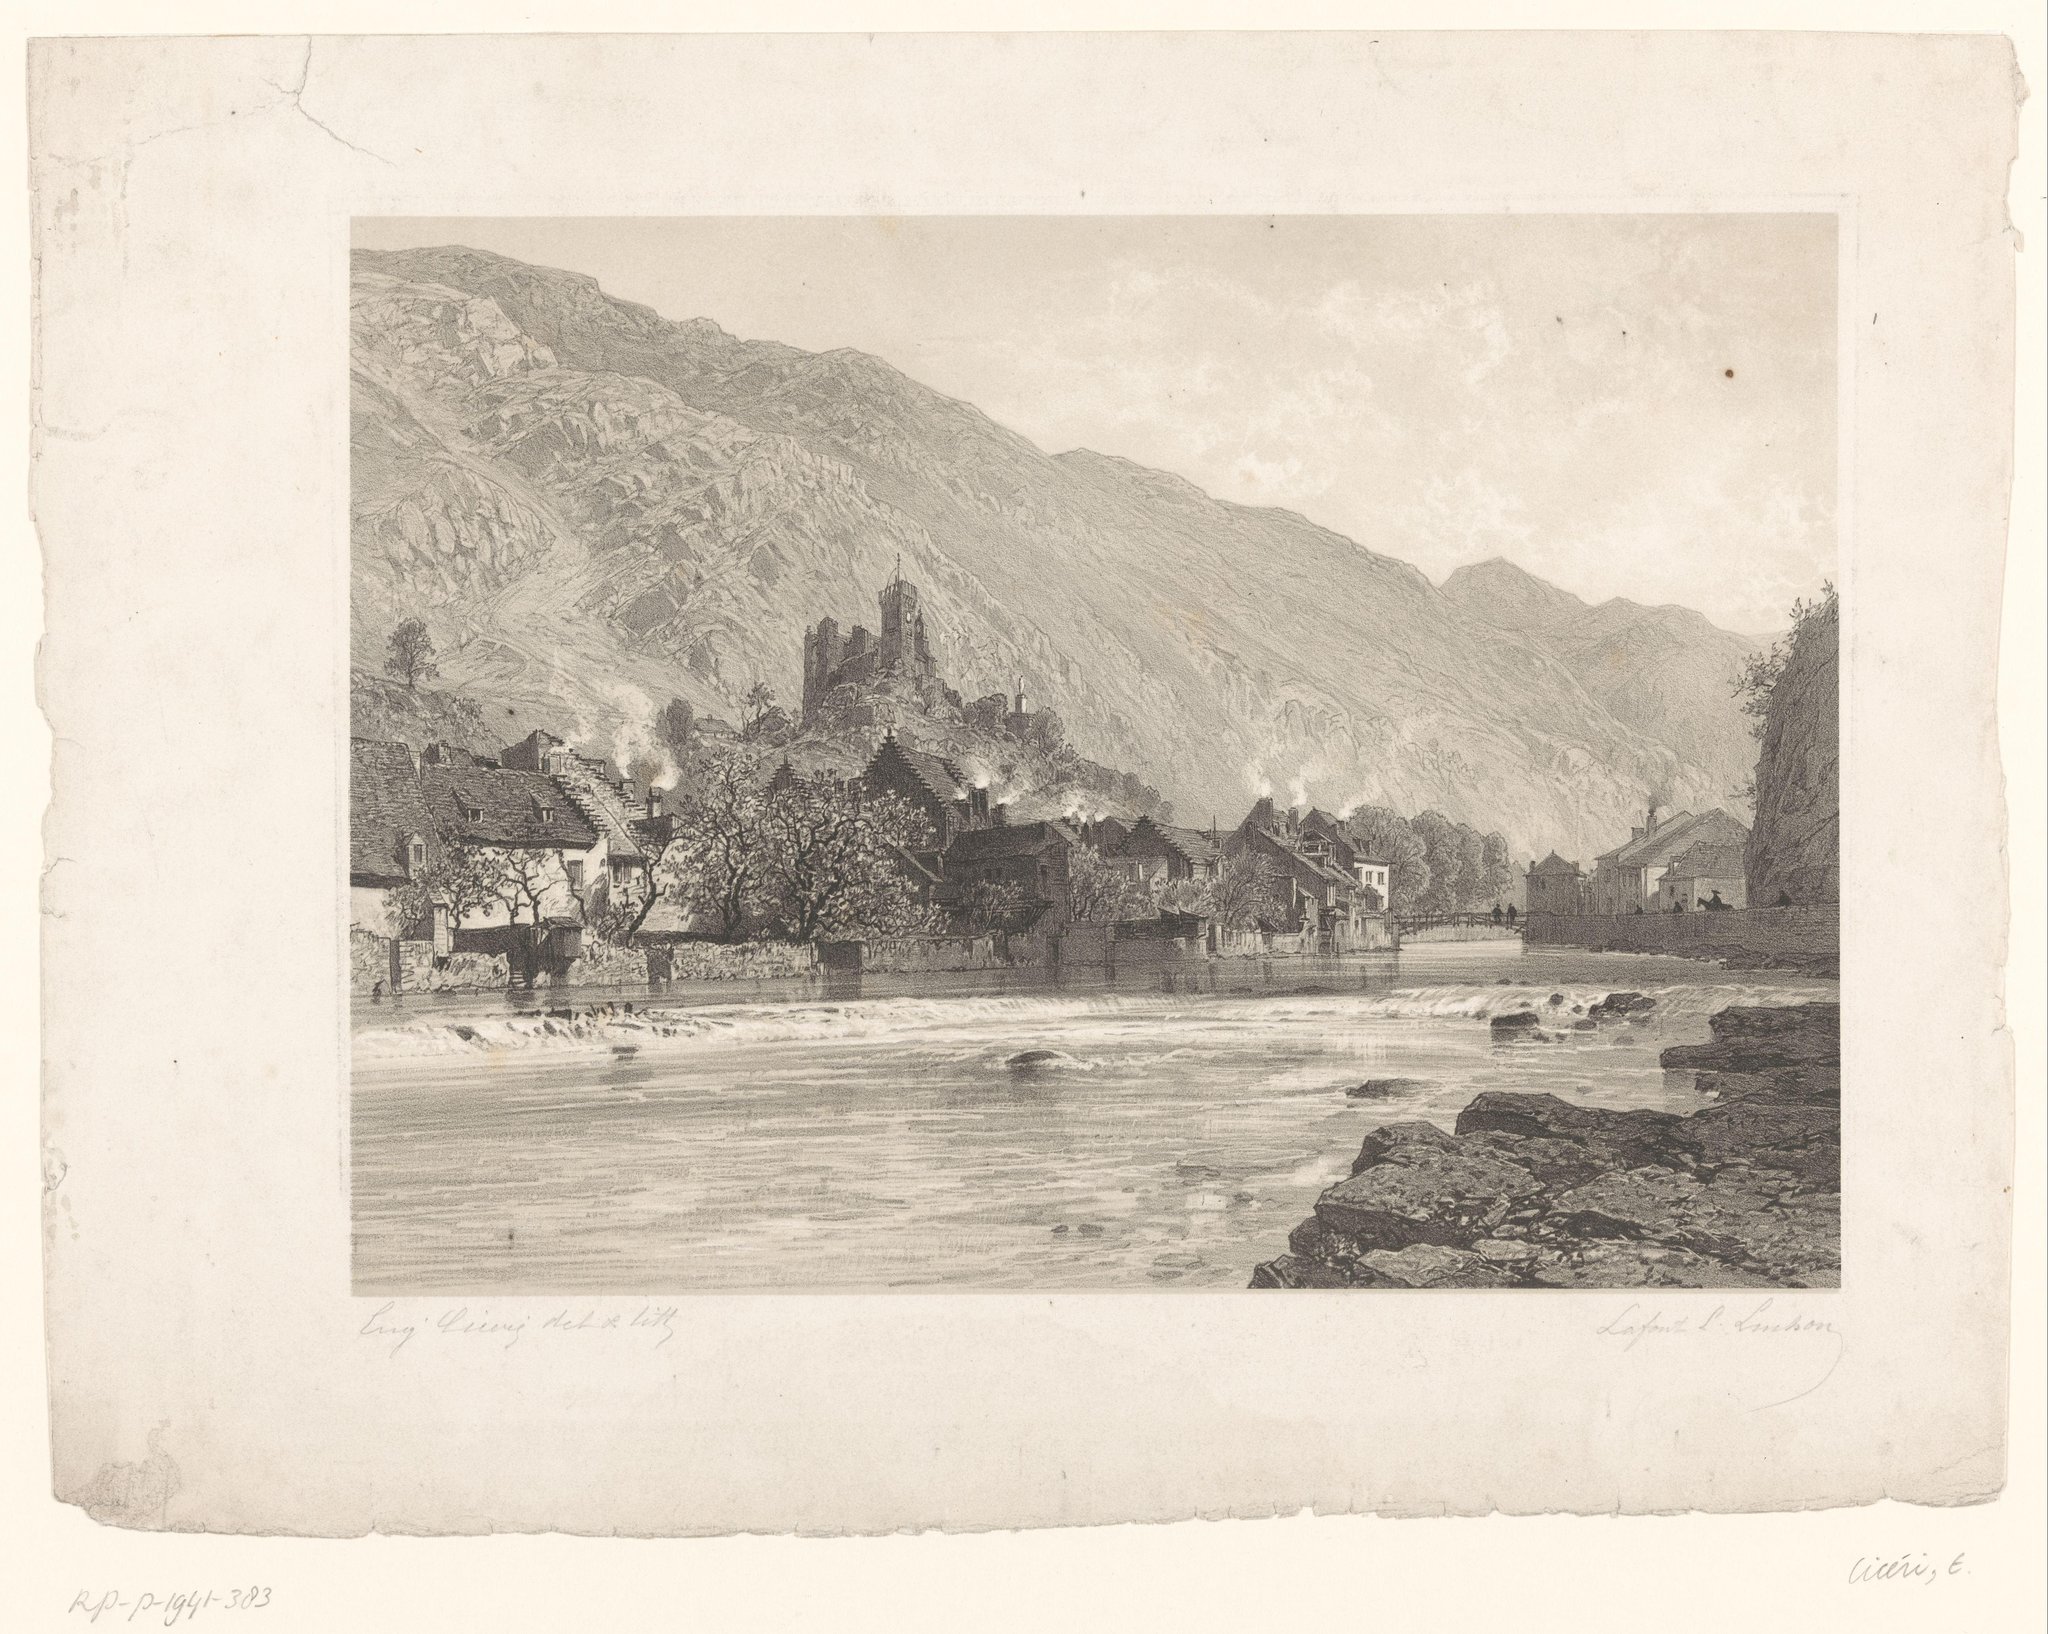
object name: print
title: Gezichten in de Pyreneeën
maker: eugène cicéri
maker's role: print maker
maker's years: 1813-1890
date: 1858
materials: paper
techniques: tone lithography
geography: paris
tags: castle, river (+ landscape with figures, staffage), mountains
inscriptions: collector's mark: Lugt 2760, collector's mark: Lugt 2228a